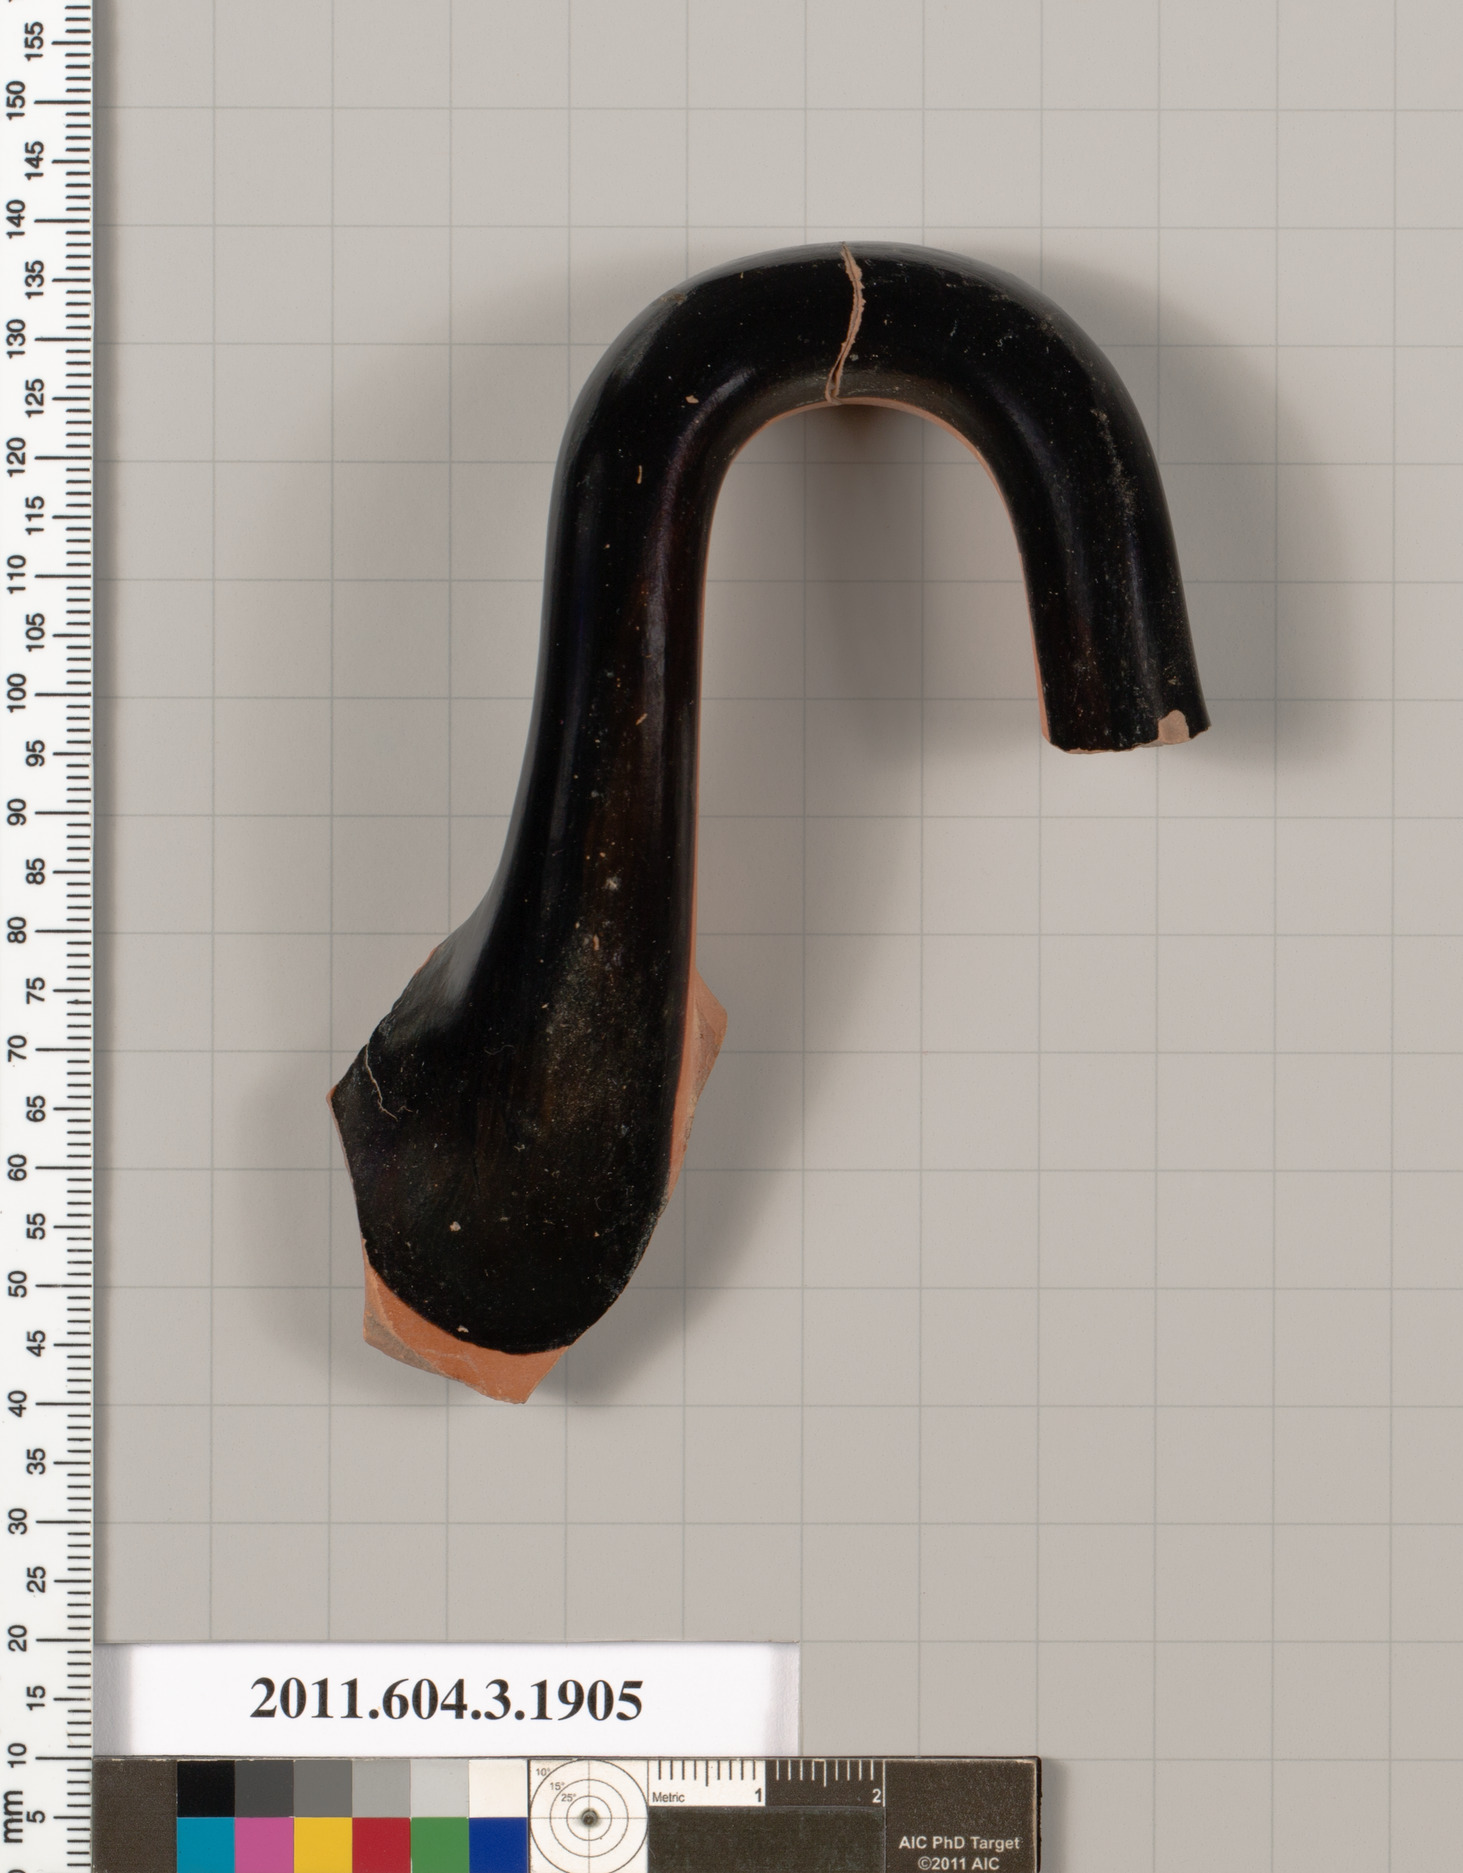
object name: kylix fragment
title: Terracotta fragment of a kylix (drinking cup)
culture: greek, attic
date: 600-401 BCE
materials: terracotta